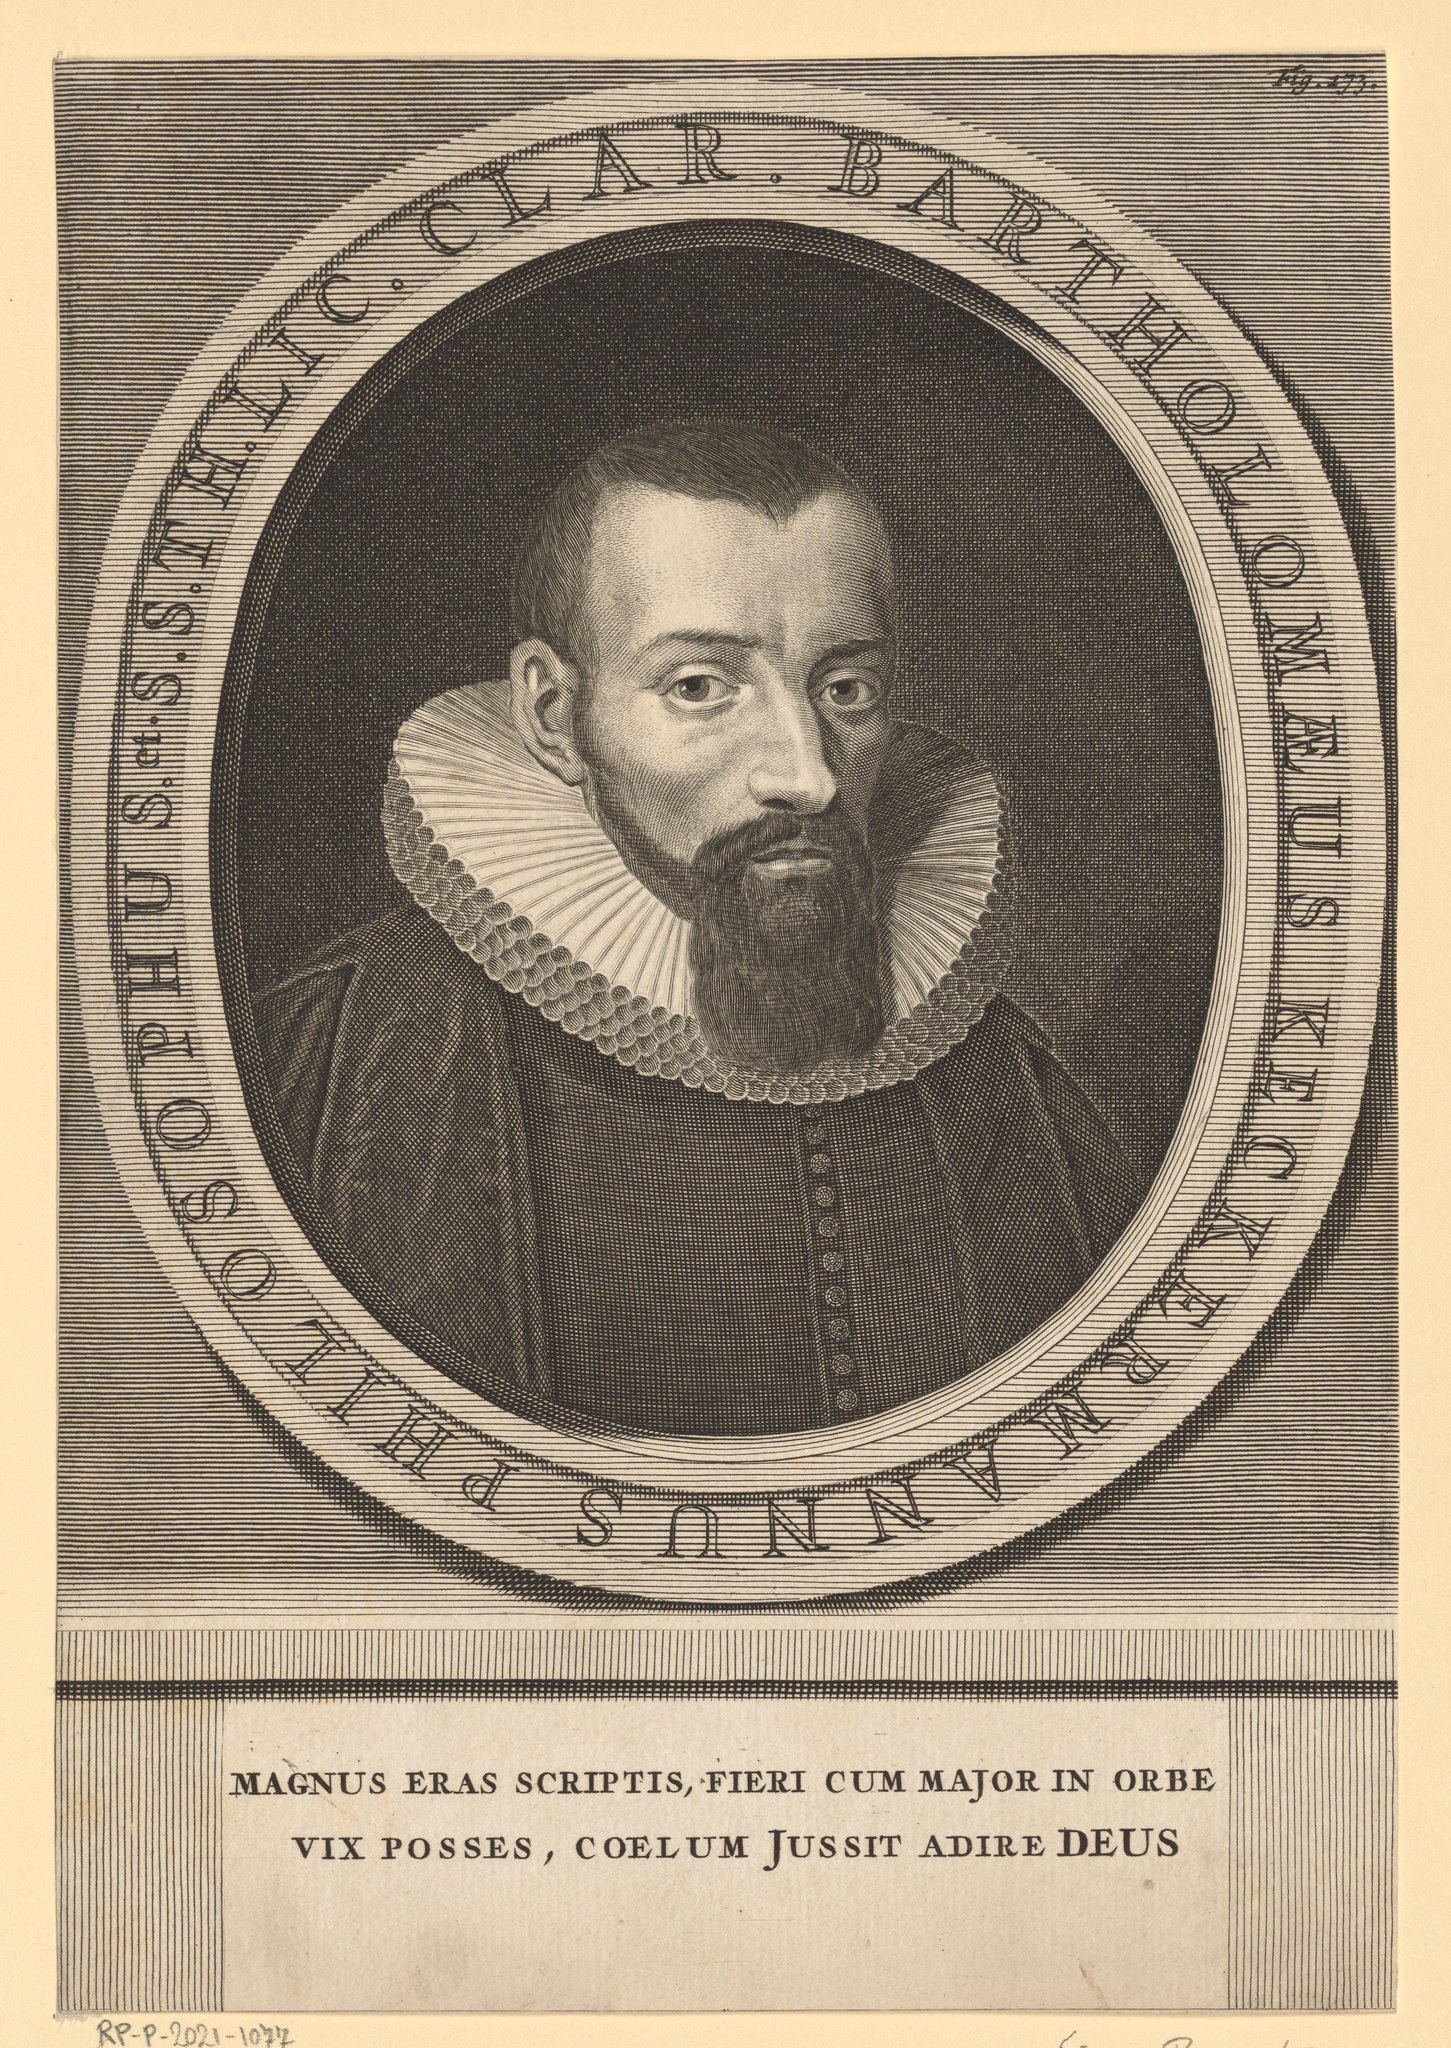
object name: print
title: Portret van Bartholomäus Keckermann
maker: Anonymous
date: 1688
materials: paper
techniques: engraving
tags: theologian, historical persons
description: Prent mogelijk uit: Curicke, Reinhold. Der Stadt Dantzig historische Beschreibung. Danzig: Johannes (II) en Gillis Janssonius van Waesberge, 1688.